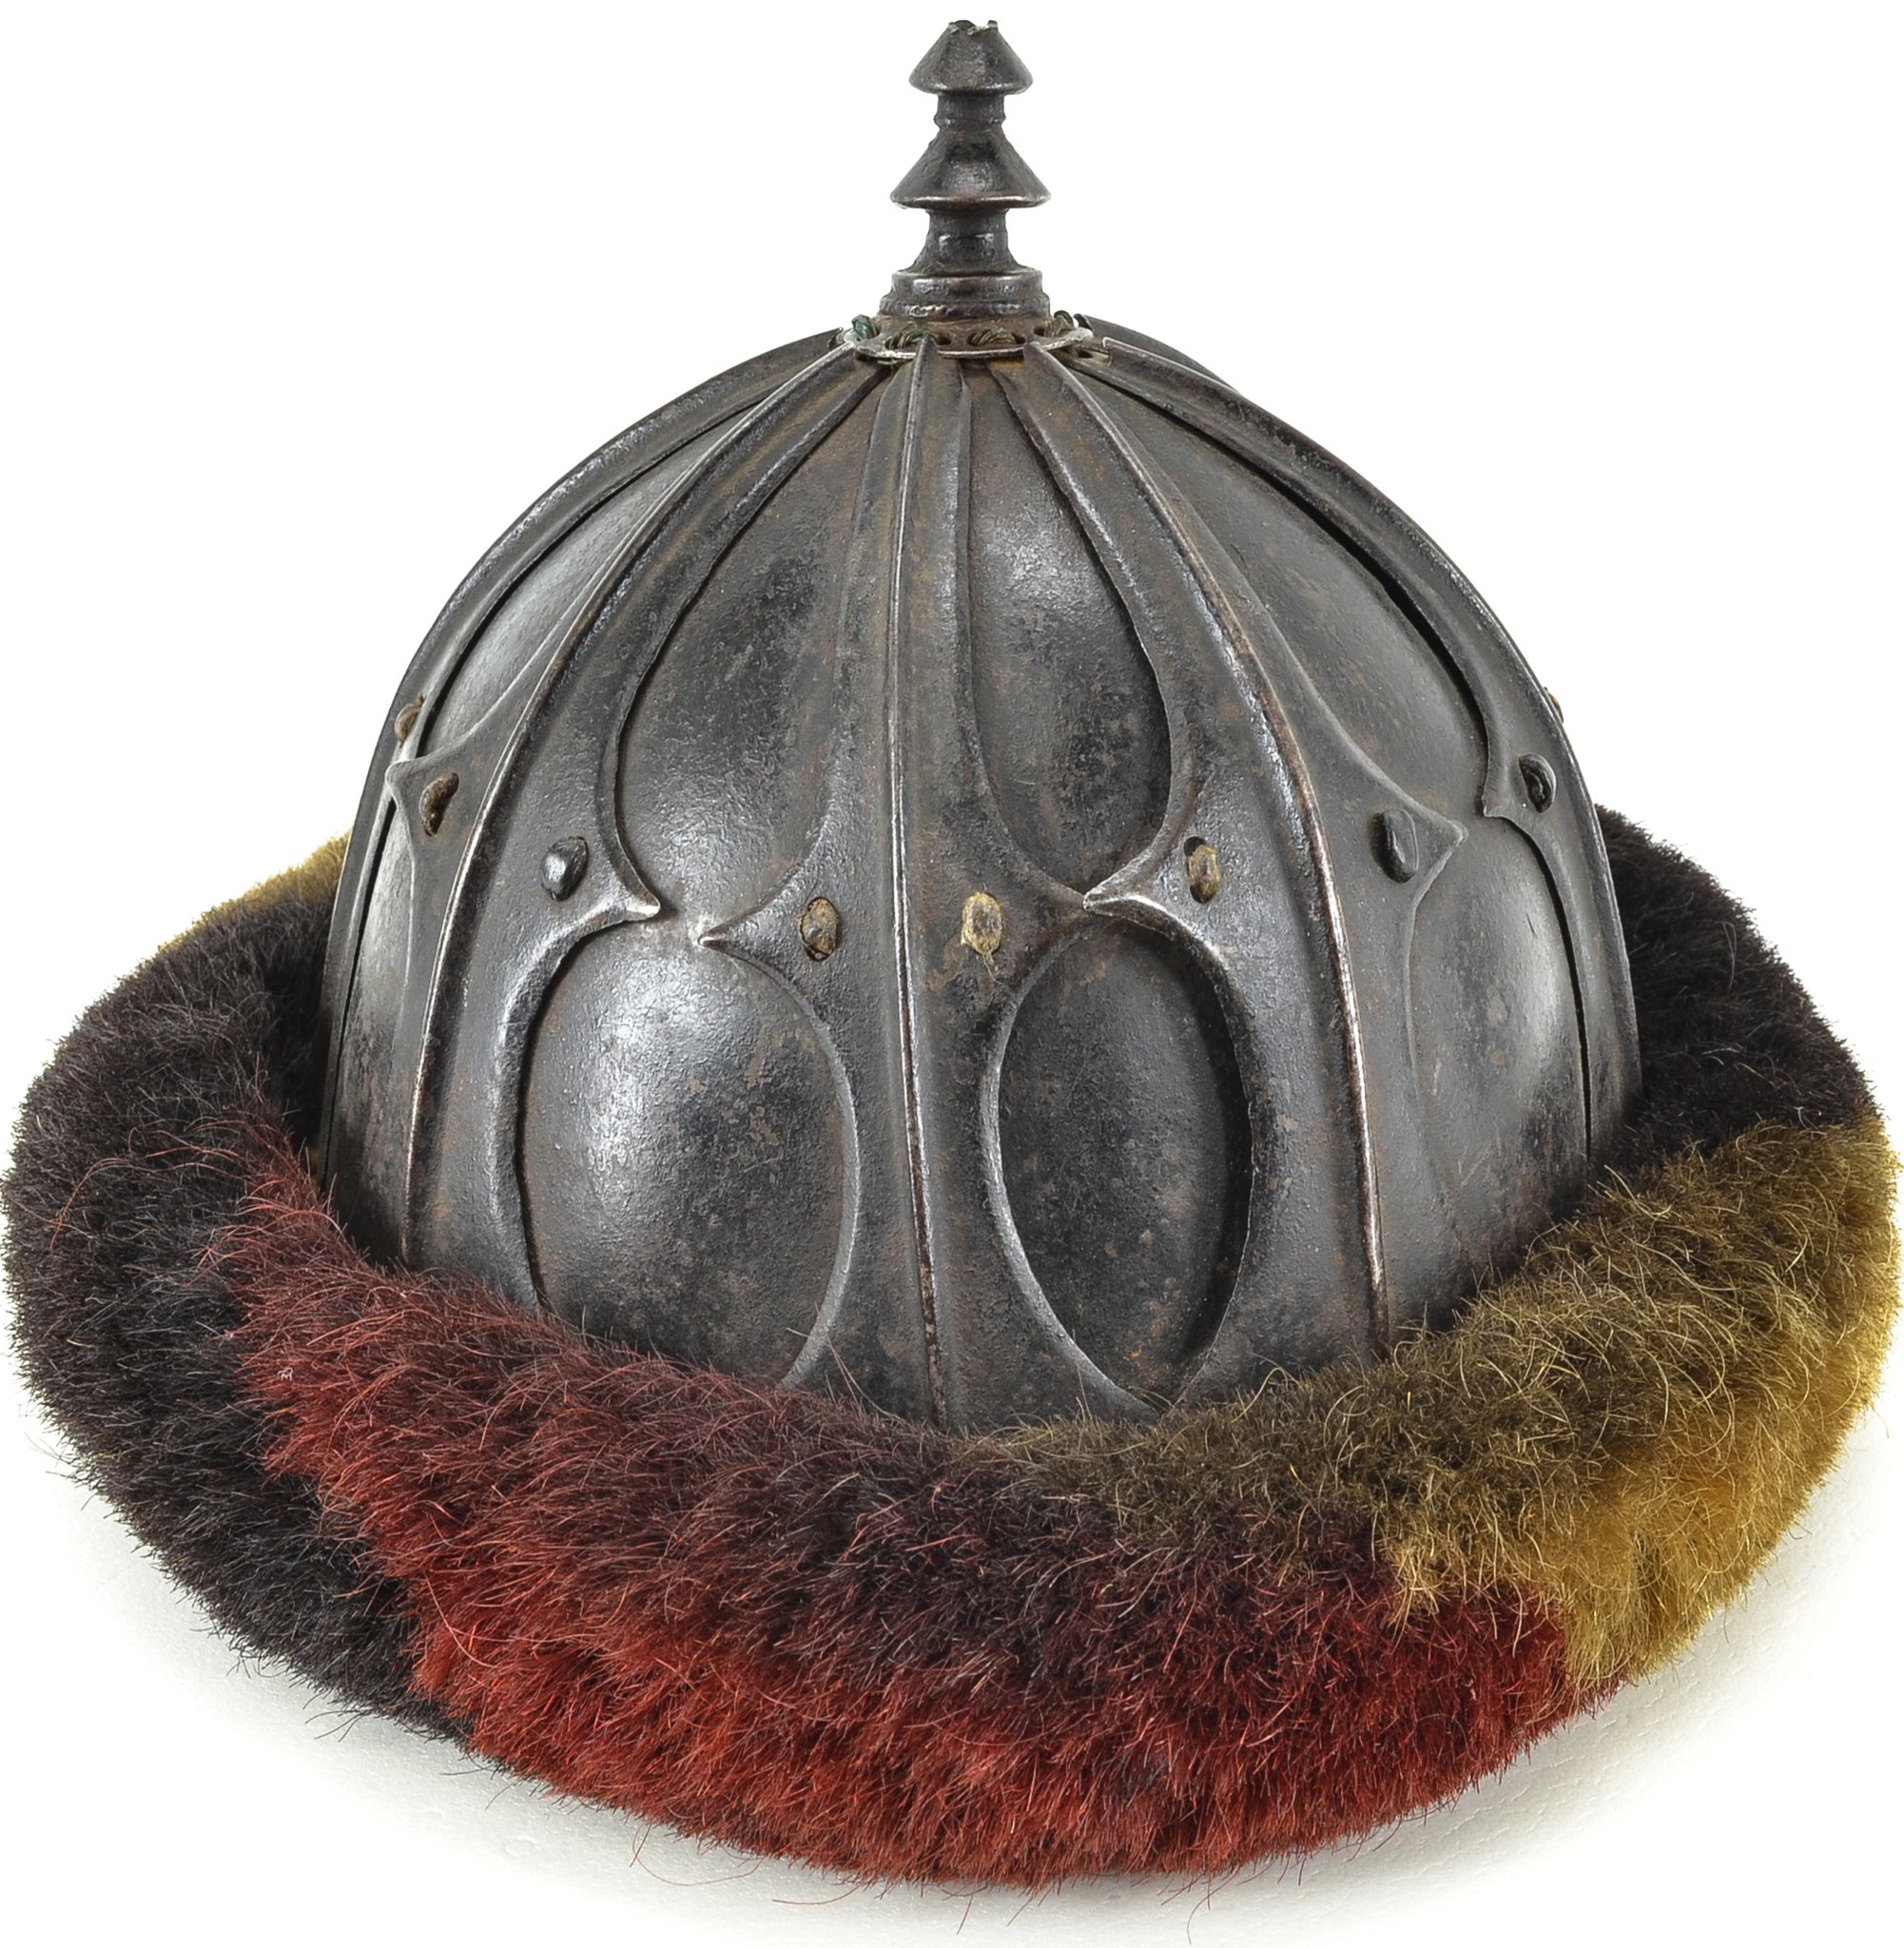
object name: sixteen plate helmet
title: Sixteen-Plate Helmet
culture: tibetan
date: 1401-1700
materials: hair, iron, leather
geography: tibet